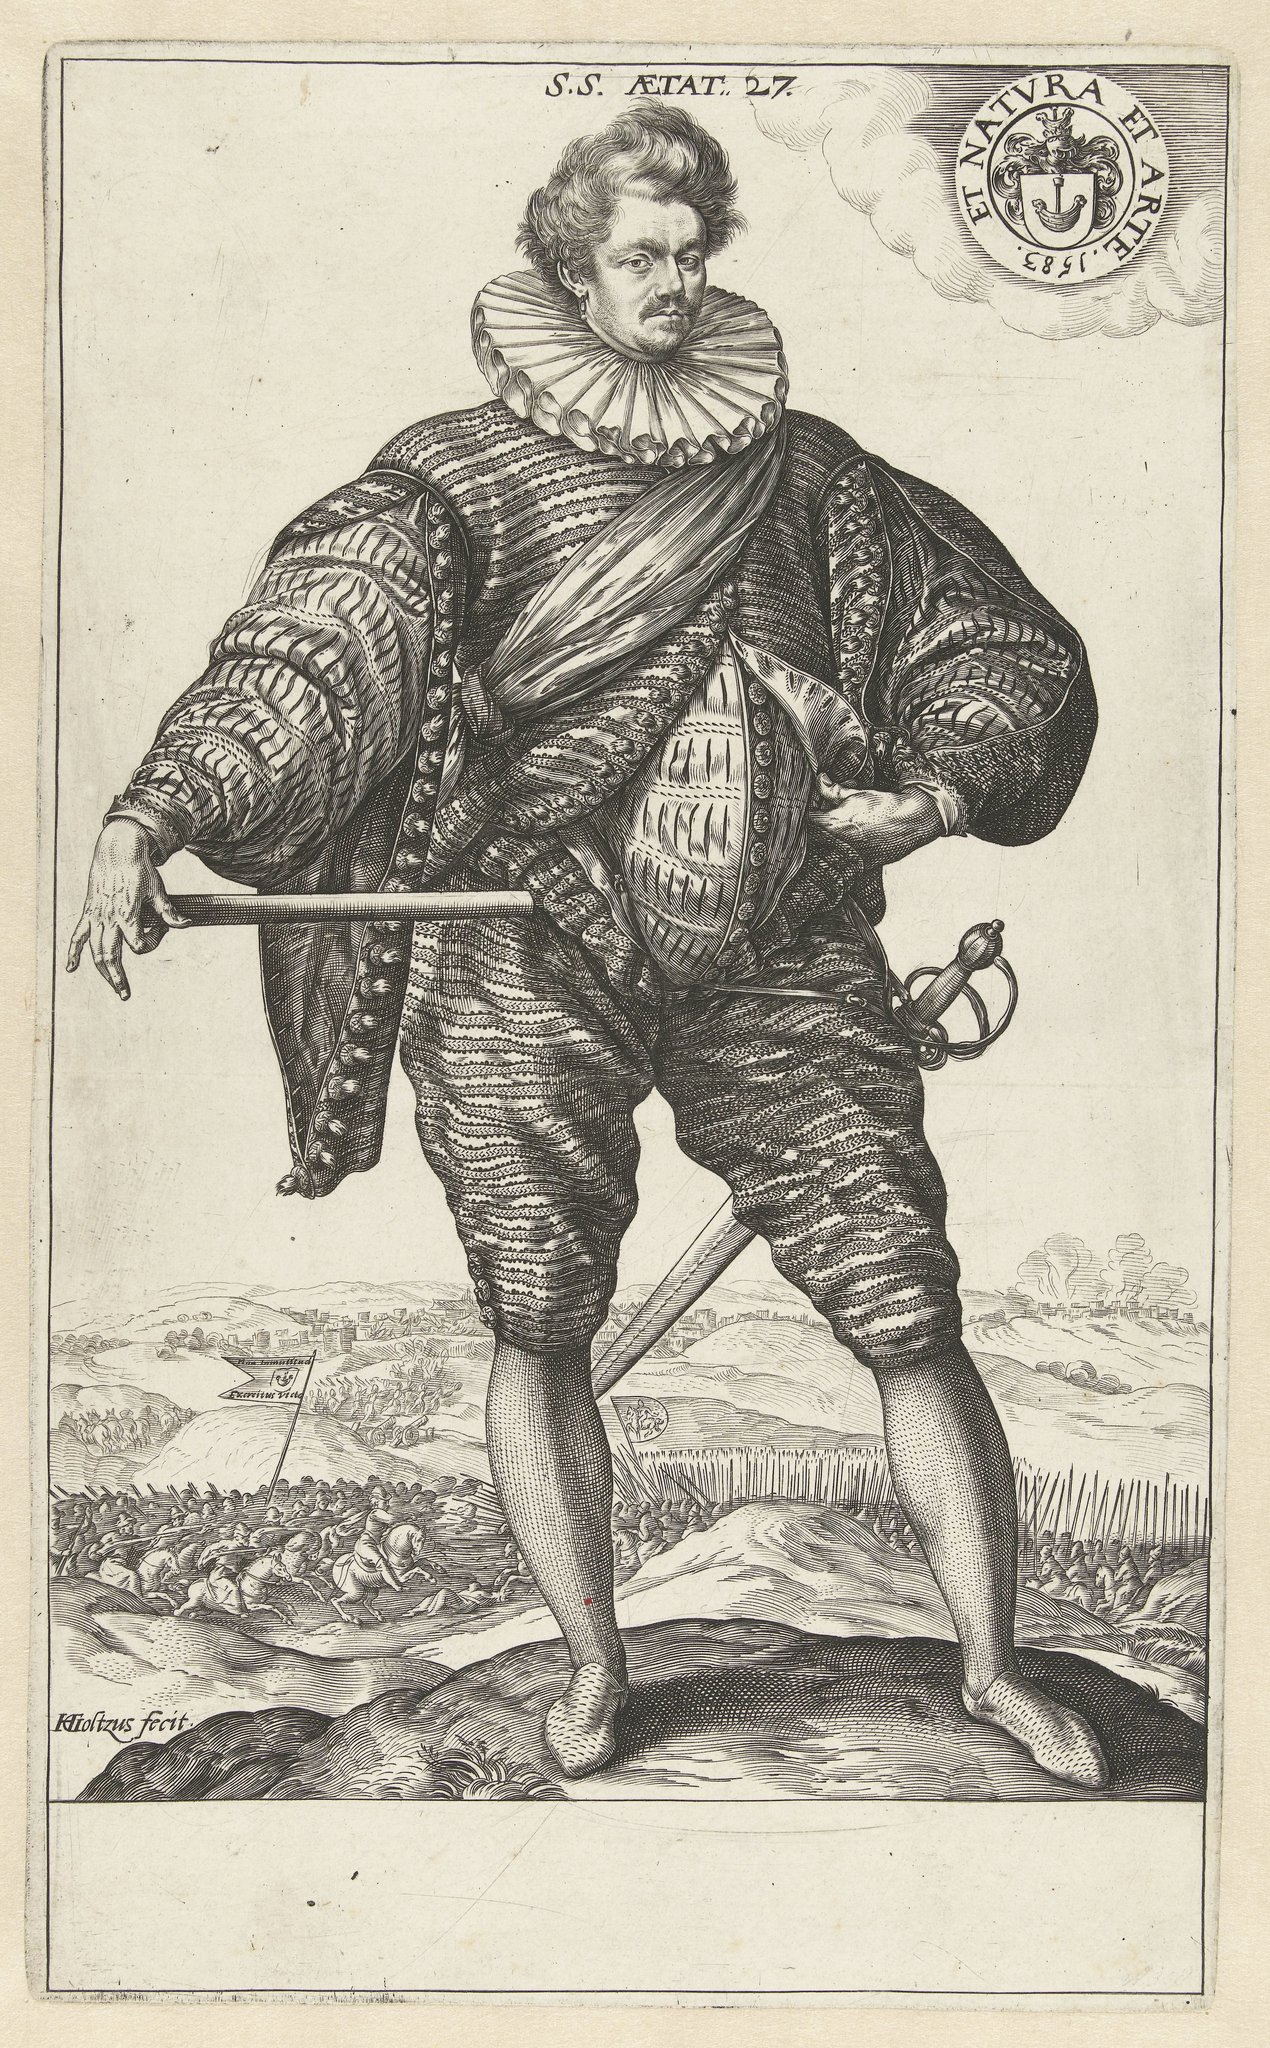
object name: print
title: Officers in Peascod Doublets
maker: hendrick goltzius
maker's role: draughtsman, painter, print maker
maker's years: 1558-1617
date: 1583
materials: paper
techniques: engraving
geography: haarlem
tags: neck-gear ~ clothing (with name) (+ men's clothes), clothing for the upper part of the body (with name) (+ men's clothes), ear-rings (+ men's clothes), coat (+ men's clothes), historical persons, battle, hacking and thrusting weapons: sword, shoes, sandals (+ men's clothes), trousers, breeches, etc. (breeches) (+ men's clothes), clothing for the upper part of the body (doublet) (+ men's clothes), stockings, socks (+ men's clothes), sleeves (+ men's clothes), netherlands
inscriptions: date: ‘1583’, inscription: ‘S.S. AETAT. 27’, signature: ‘HGoltzius fecit.’, collector's mark: Lugt 240, inscription: ‘ET NATURA ET ARTE.’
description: From the beginning of the 16th century, good posture dictated that the shoulders should be thrown back and the breast thrust out. This contemporary ideal of beauty was emphasized by padding the front of the doublet, creating a peascod belly. Goltzius and De Gheyn exploited this fashion to make their officers appear more courageous and combative.